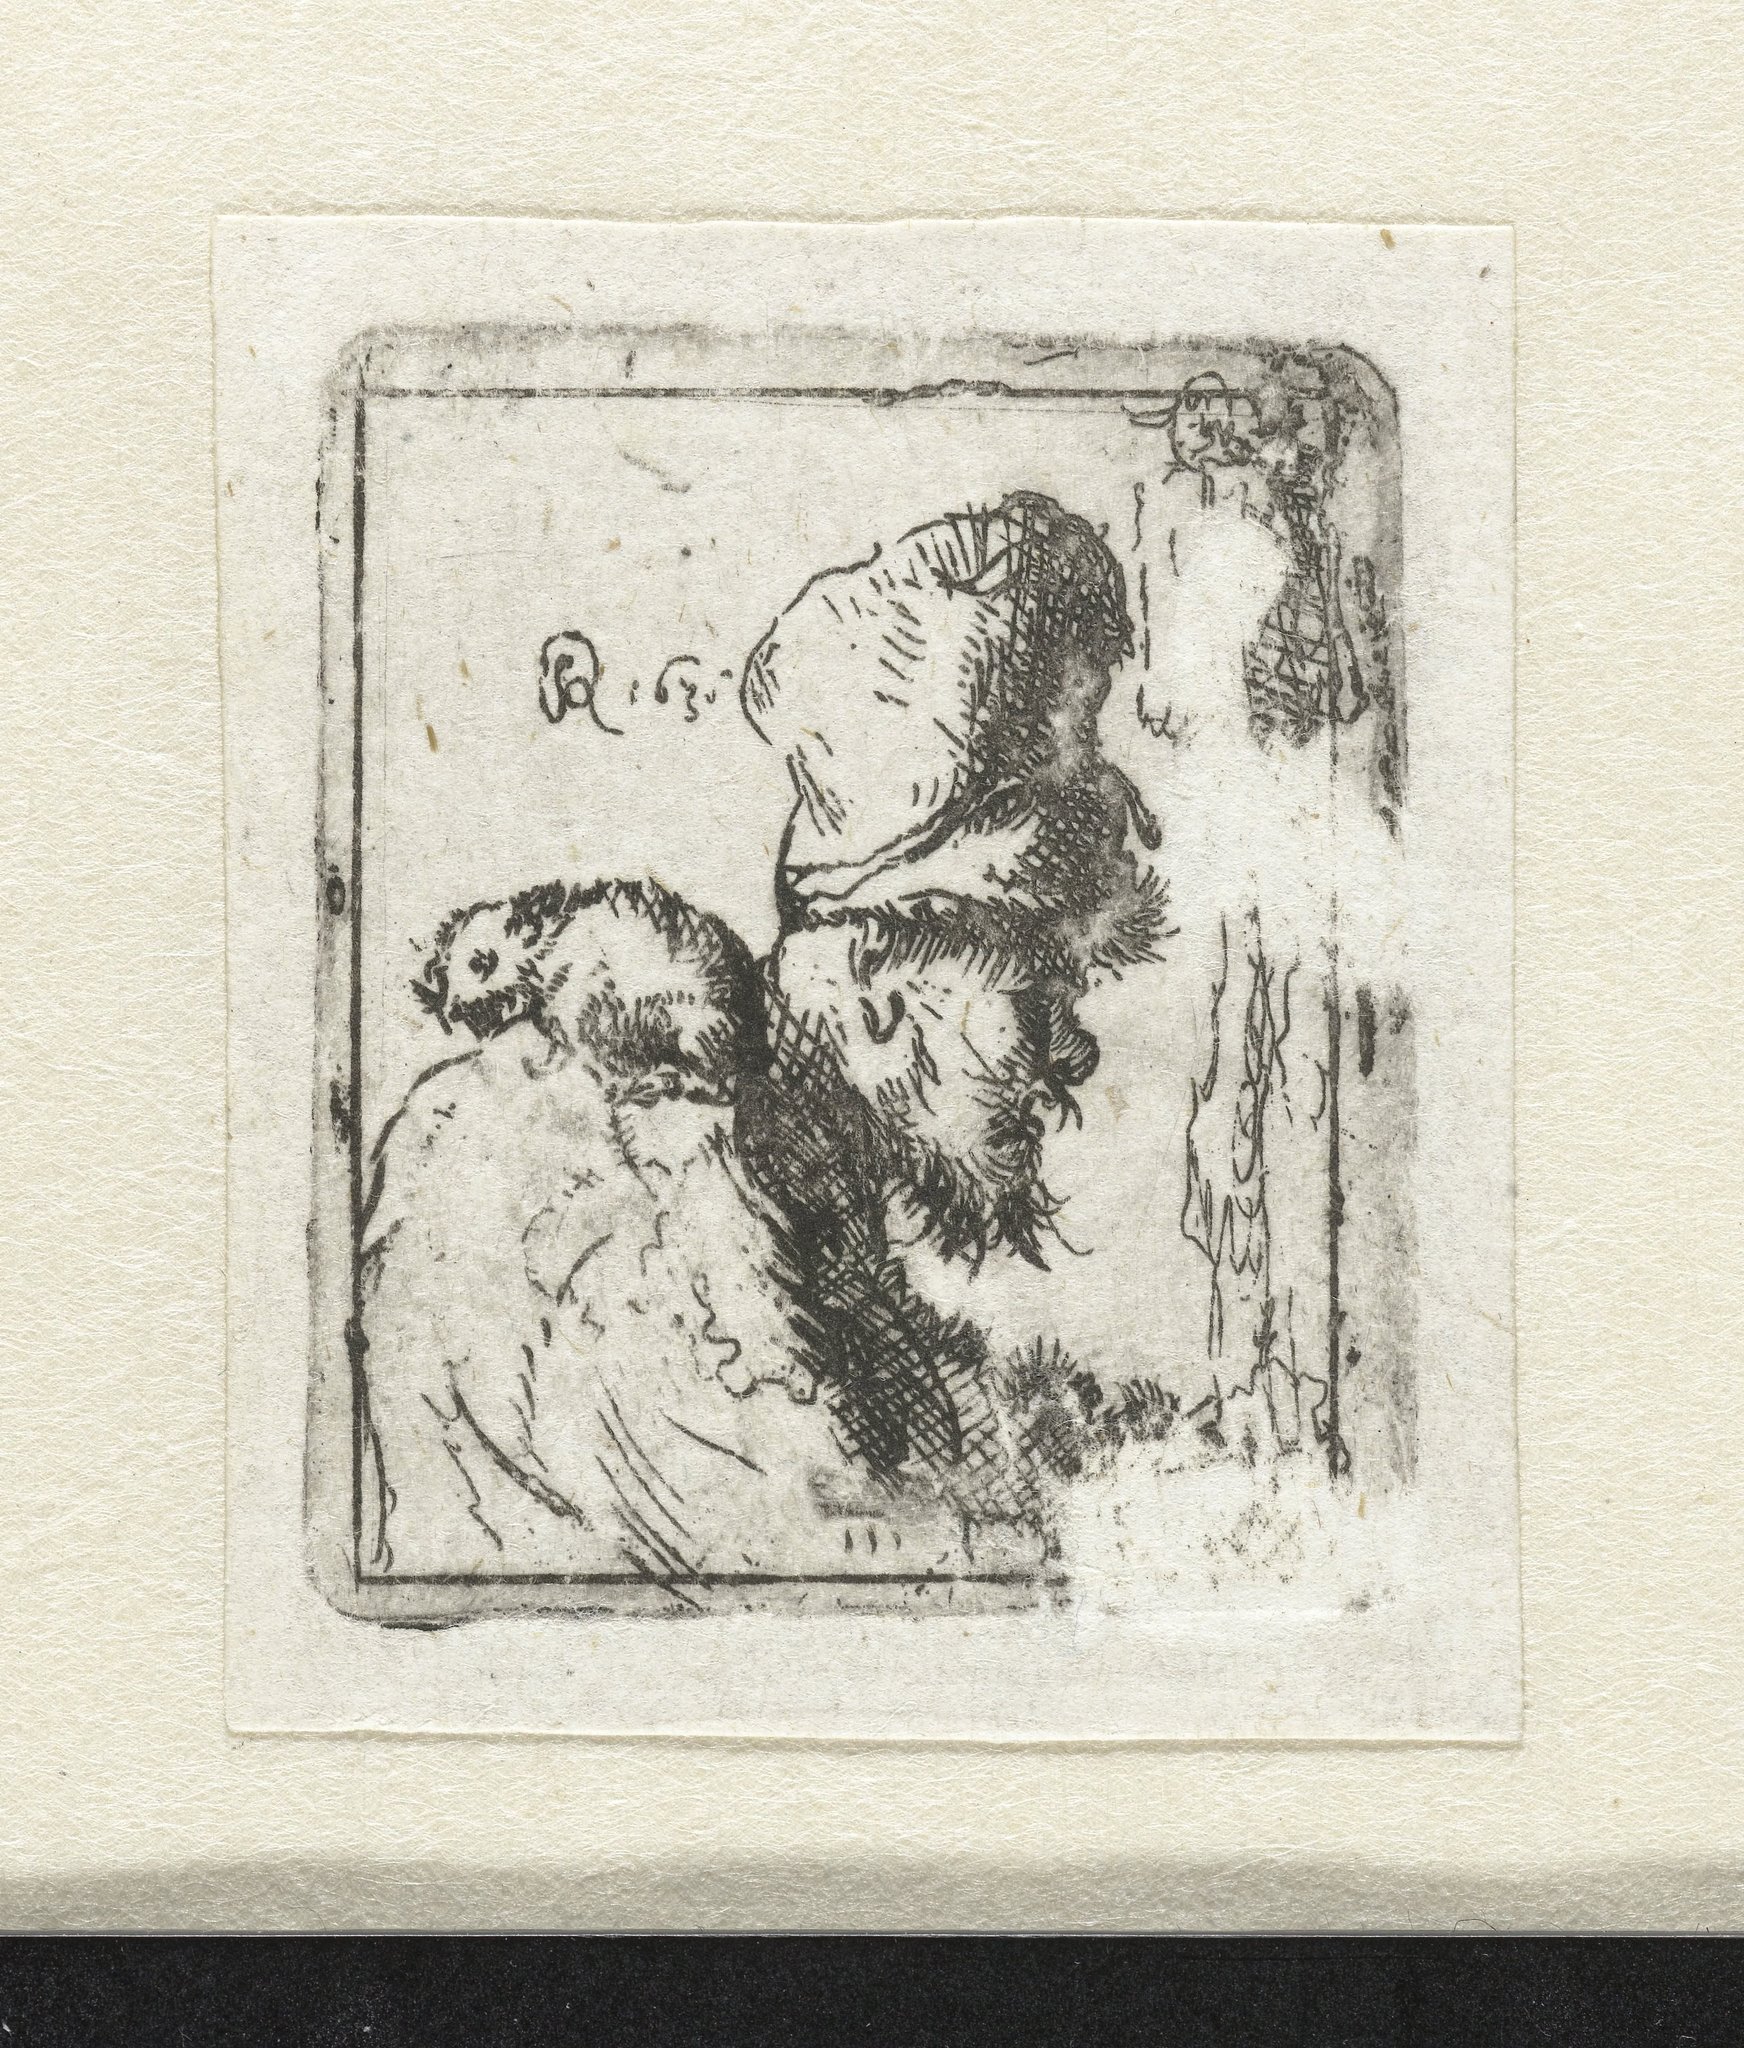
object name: print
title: The rat catcher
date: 1632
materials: paper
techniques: etching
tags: rat exterminator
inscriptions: collector's mark: Lugt 240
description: Spiegelbeeldige kopie naar een gedeelte van de gelijknamige prent van Rembrandt.